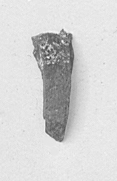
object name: chisel fragment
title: Chisel Fragment From Foundation Deposit 2 of Hatshepsut's Valley Temple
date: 1479-1458 BCE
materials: bronze, copper alloy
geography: egypt